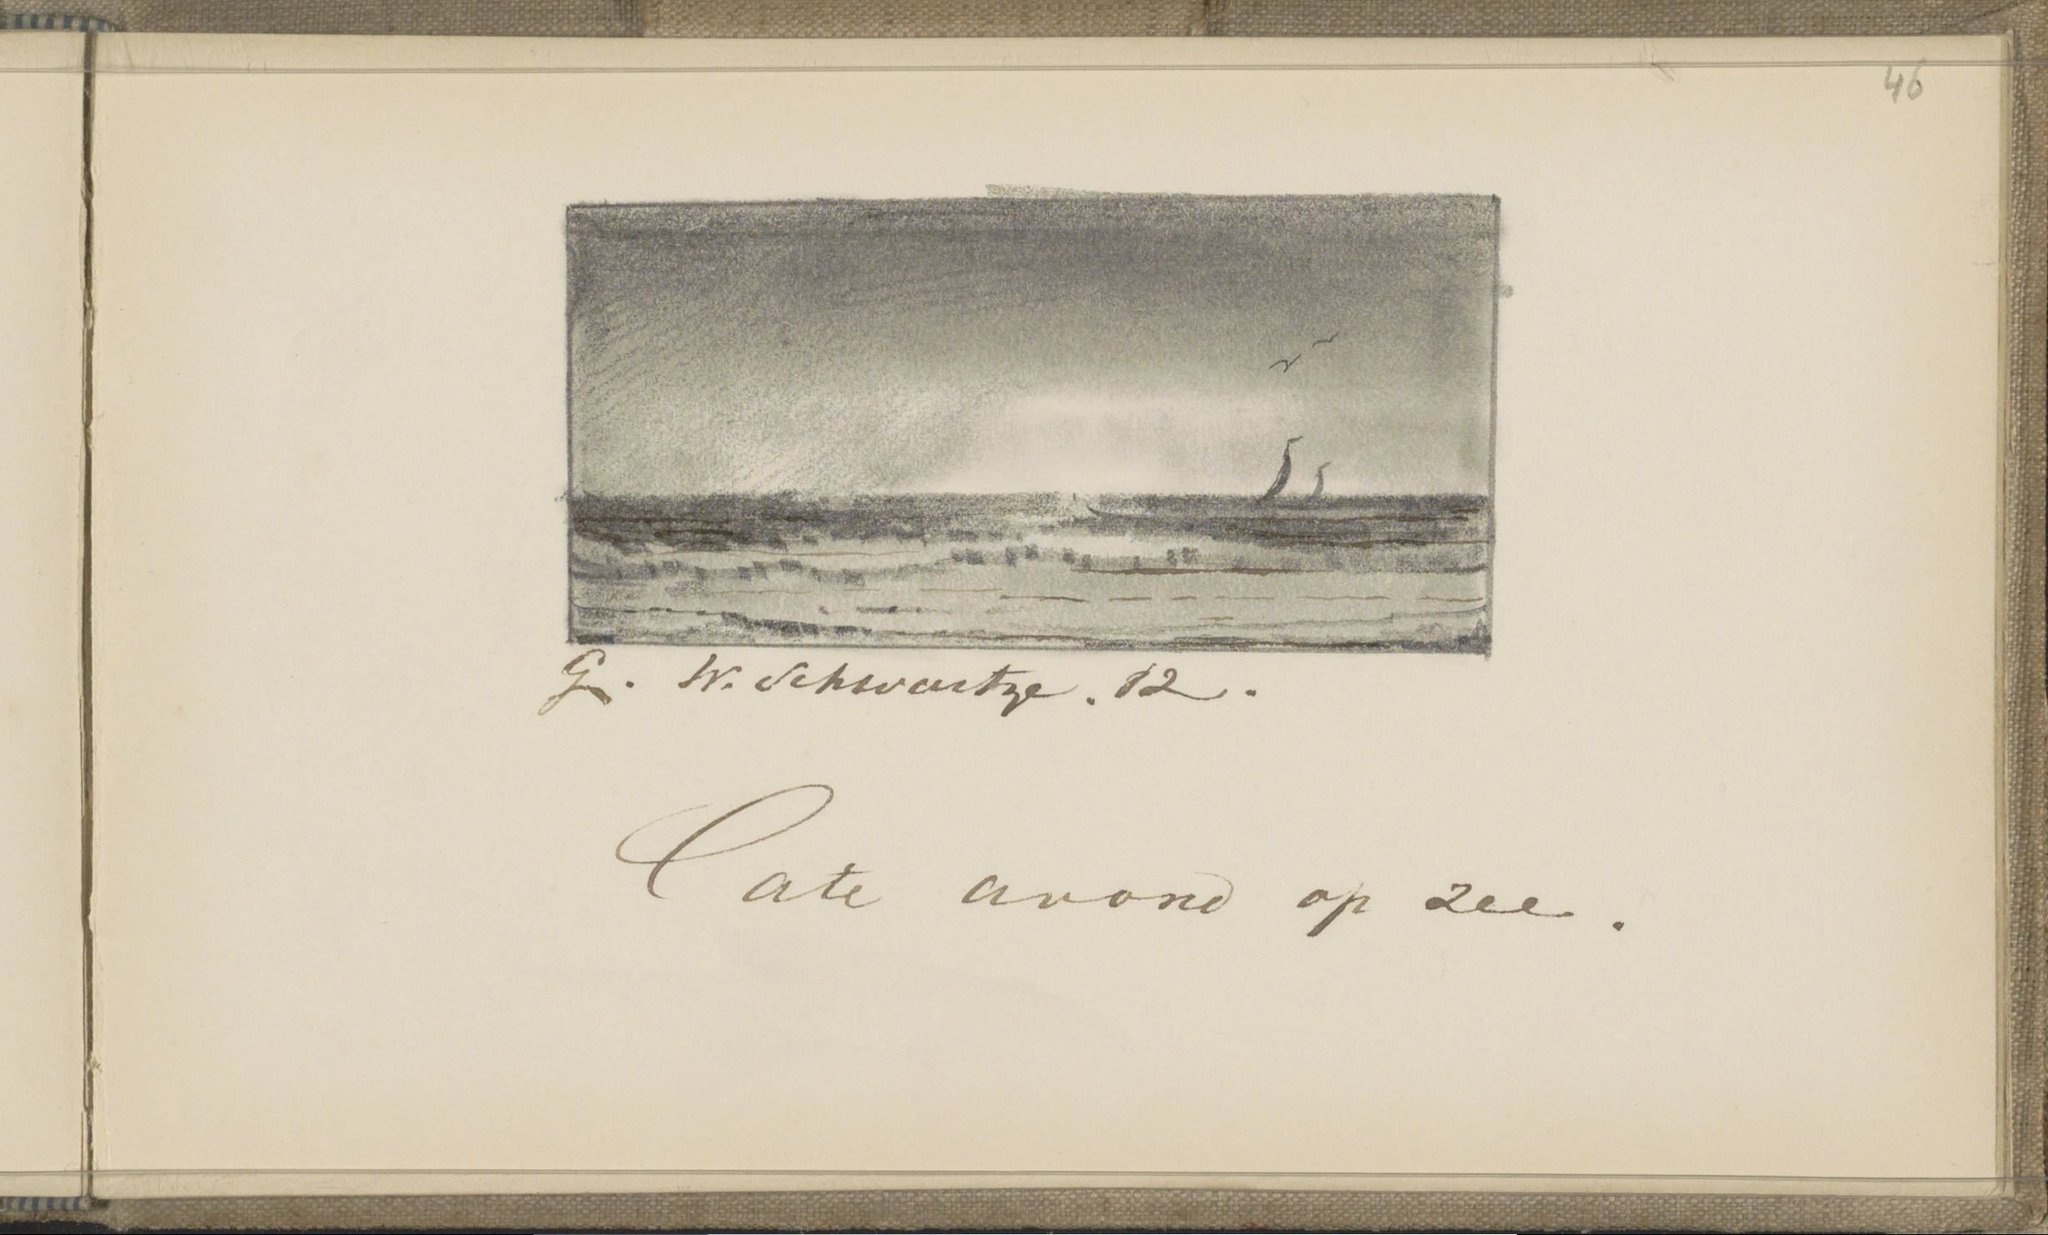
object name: sketchbook leaf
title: Zeegezicht met avondlicht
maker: george washington schwartze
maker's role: draughtsman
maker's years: 1857-1909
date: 1882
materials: paper, pencil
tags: dusk, evening twilight, sea (seascape)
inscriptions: title: ‘Late avond op zee.’, signature and date: ‘G.W. Schwartze. 1882.’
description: Tekening in een kader. Blad 46 recto uit een schetsboek met 54 bladen.